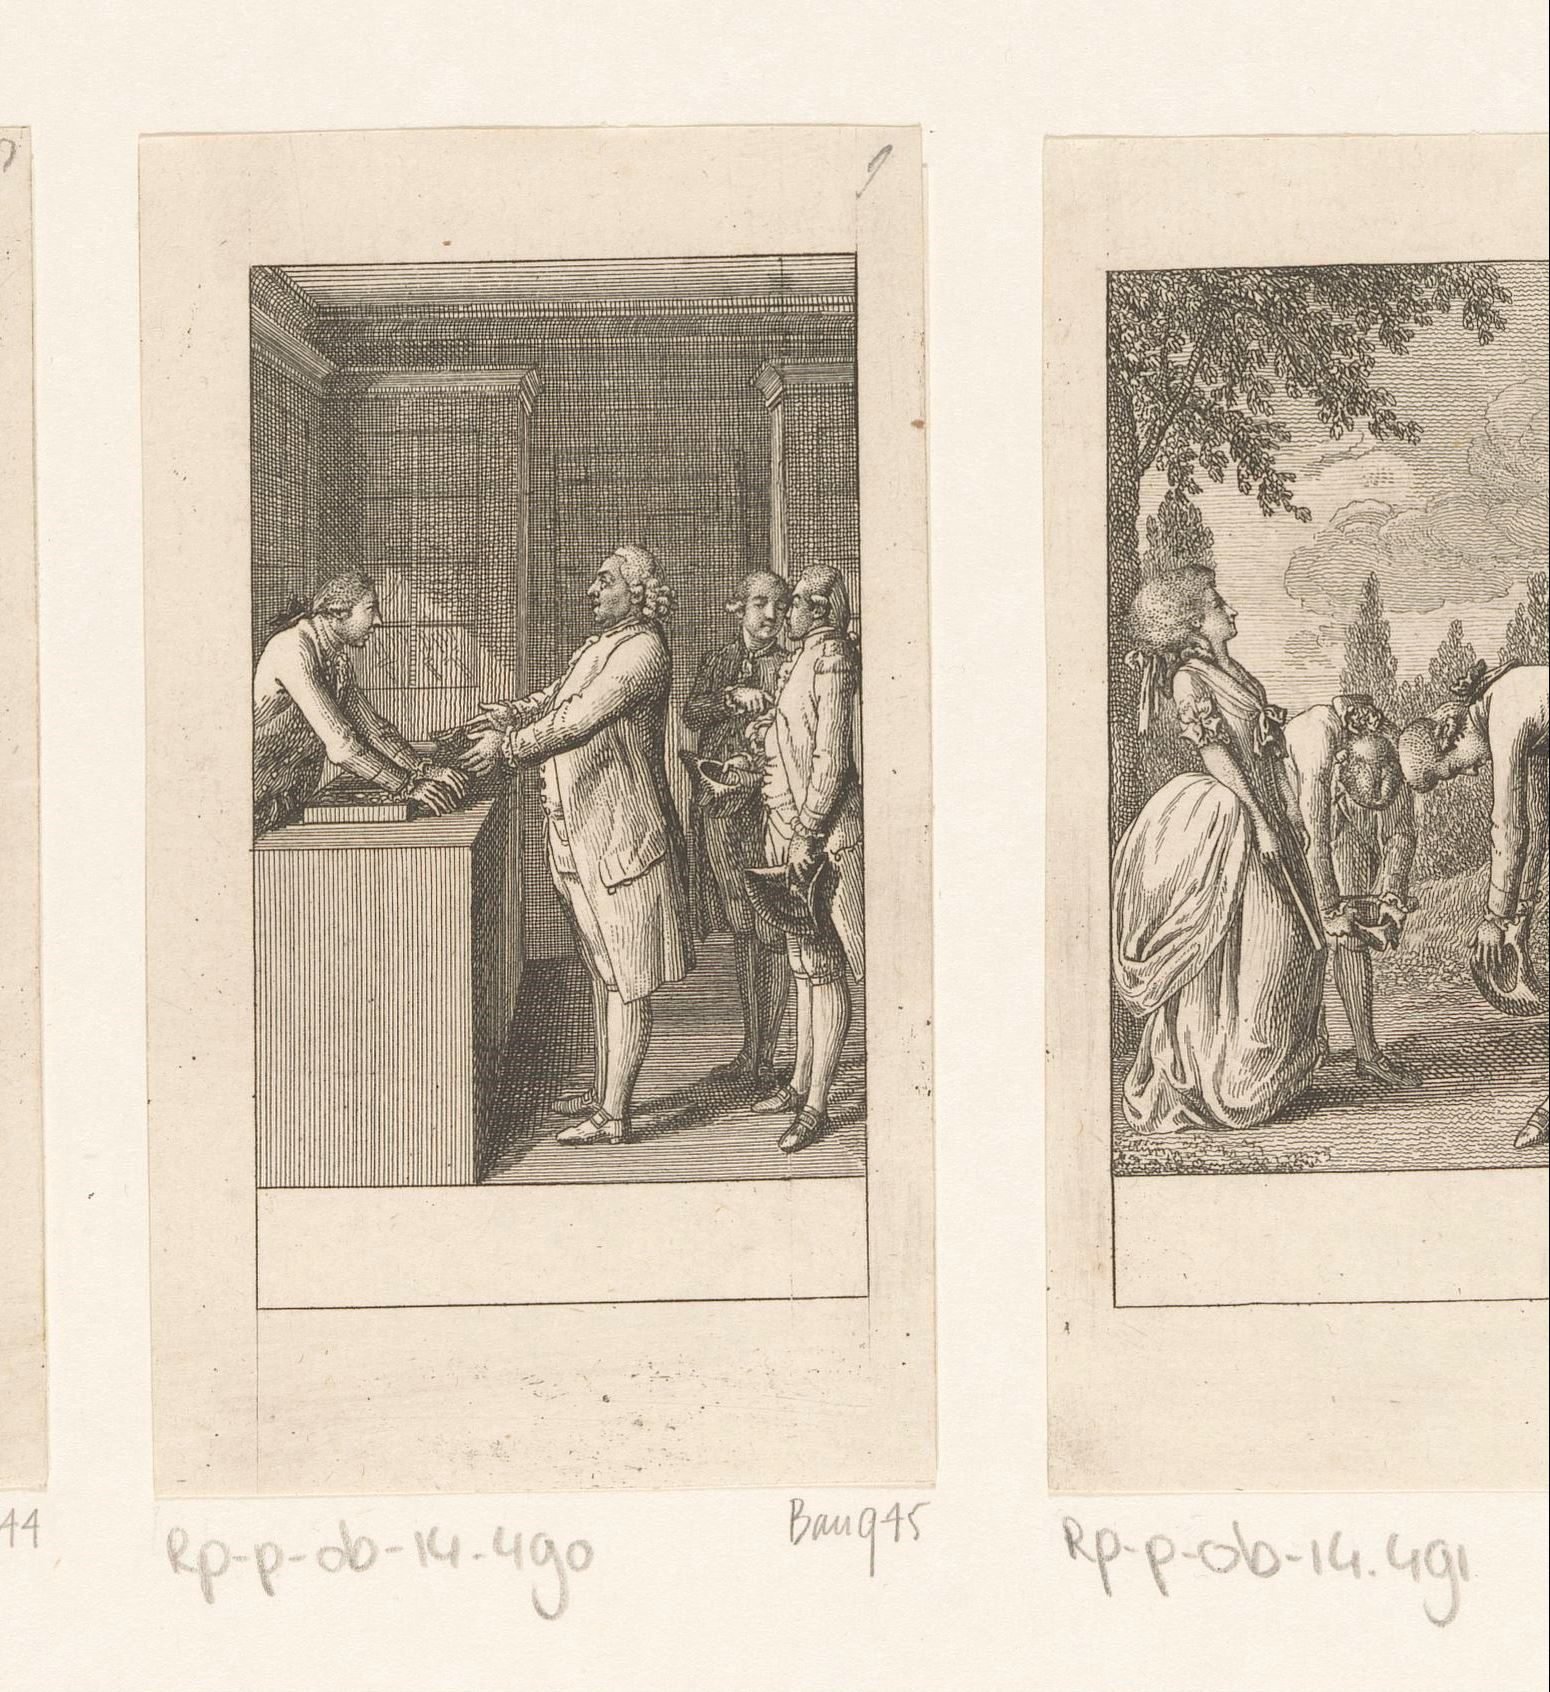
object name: print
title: Financiële dwaasheid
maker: daniel nikolaus chodowiecki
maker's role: draughtsman, print maker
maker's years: 1726-1801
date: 1782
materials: paper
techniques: etching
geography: berlin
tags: fool, simpleton, numskull, credit, banker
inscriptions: collector's mark: Lugt 2228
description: Vervaardigd voor Sancta Clara's 'Centifolium Stultorum'. Latere staat gebruikt voor: Goettinger Taschen Calender vom Jahr 1783. bey Joh. Chr. Dietrich. Göttingen: Georg Christoph Lichtenberg, 1782.